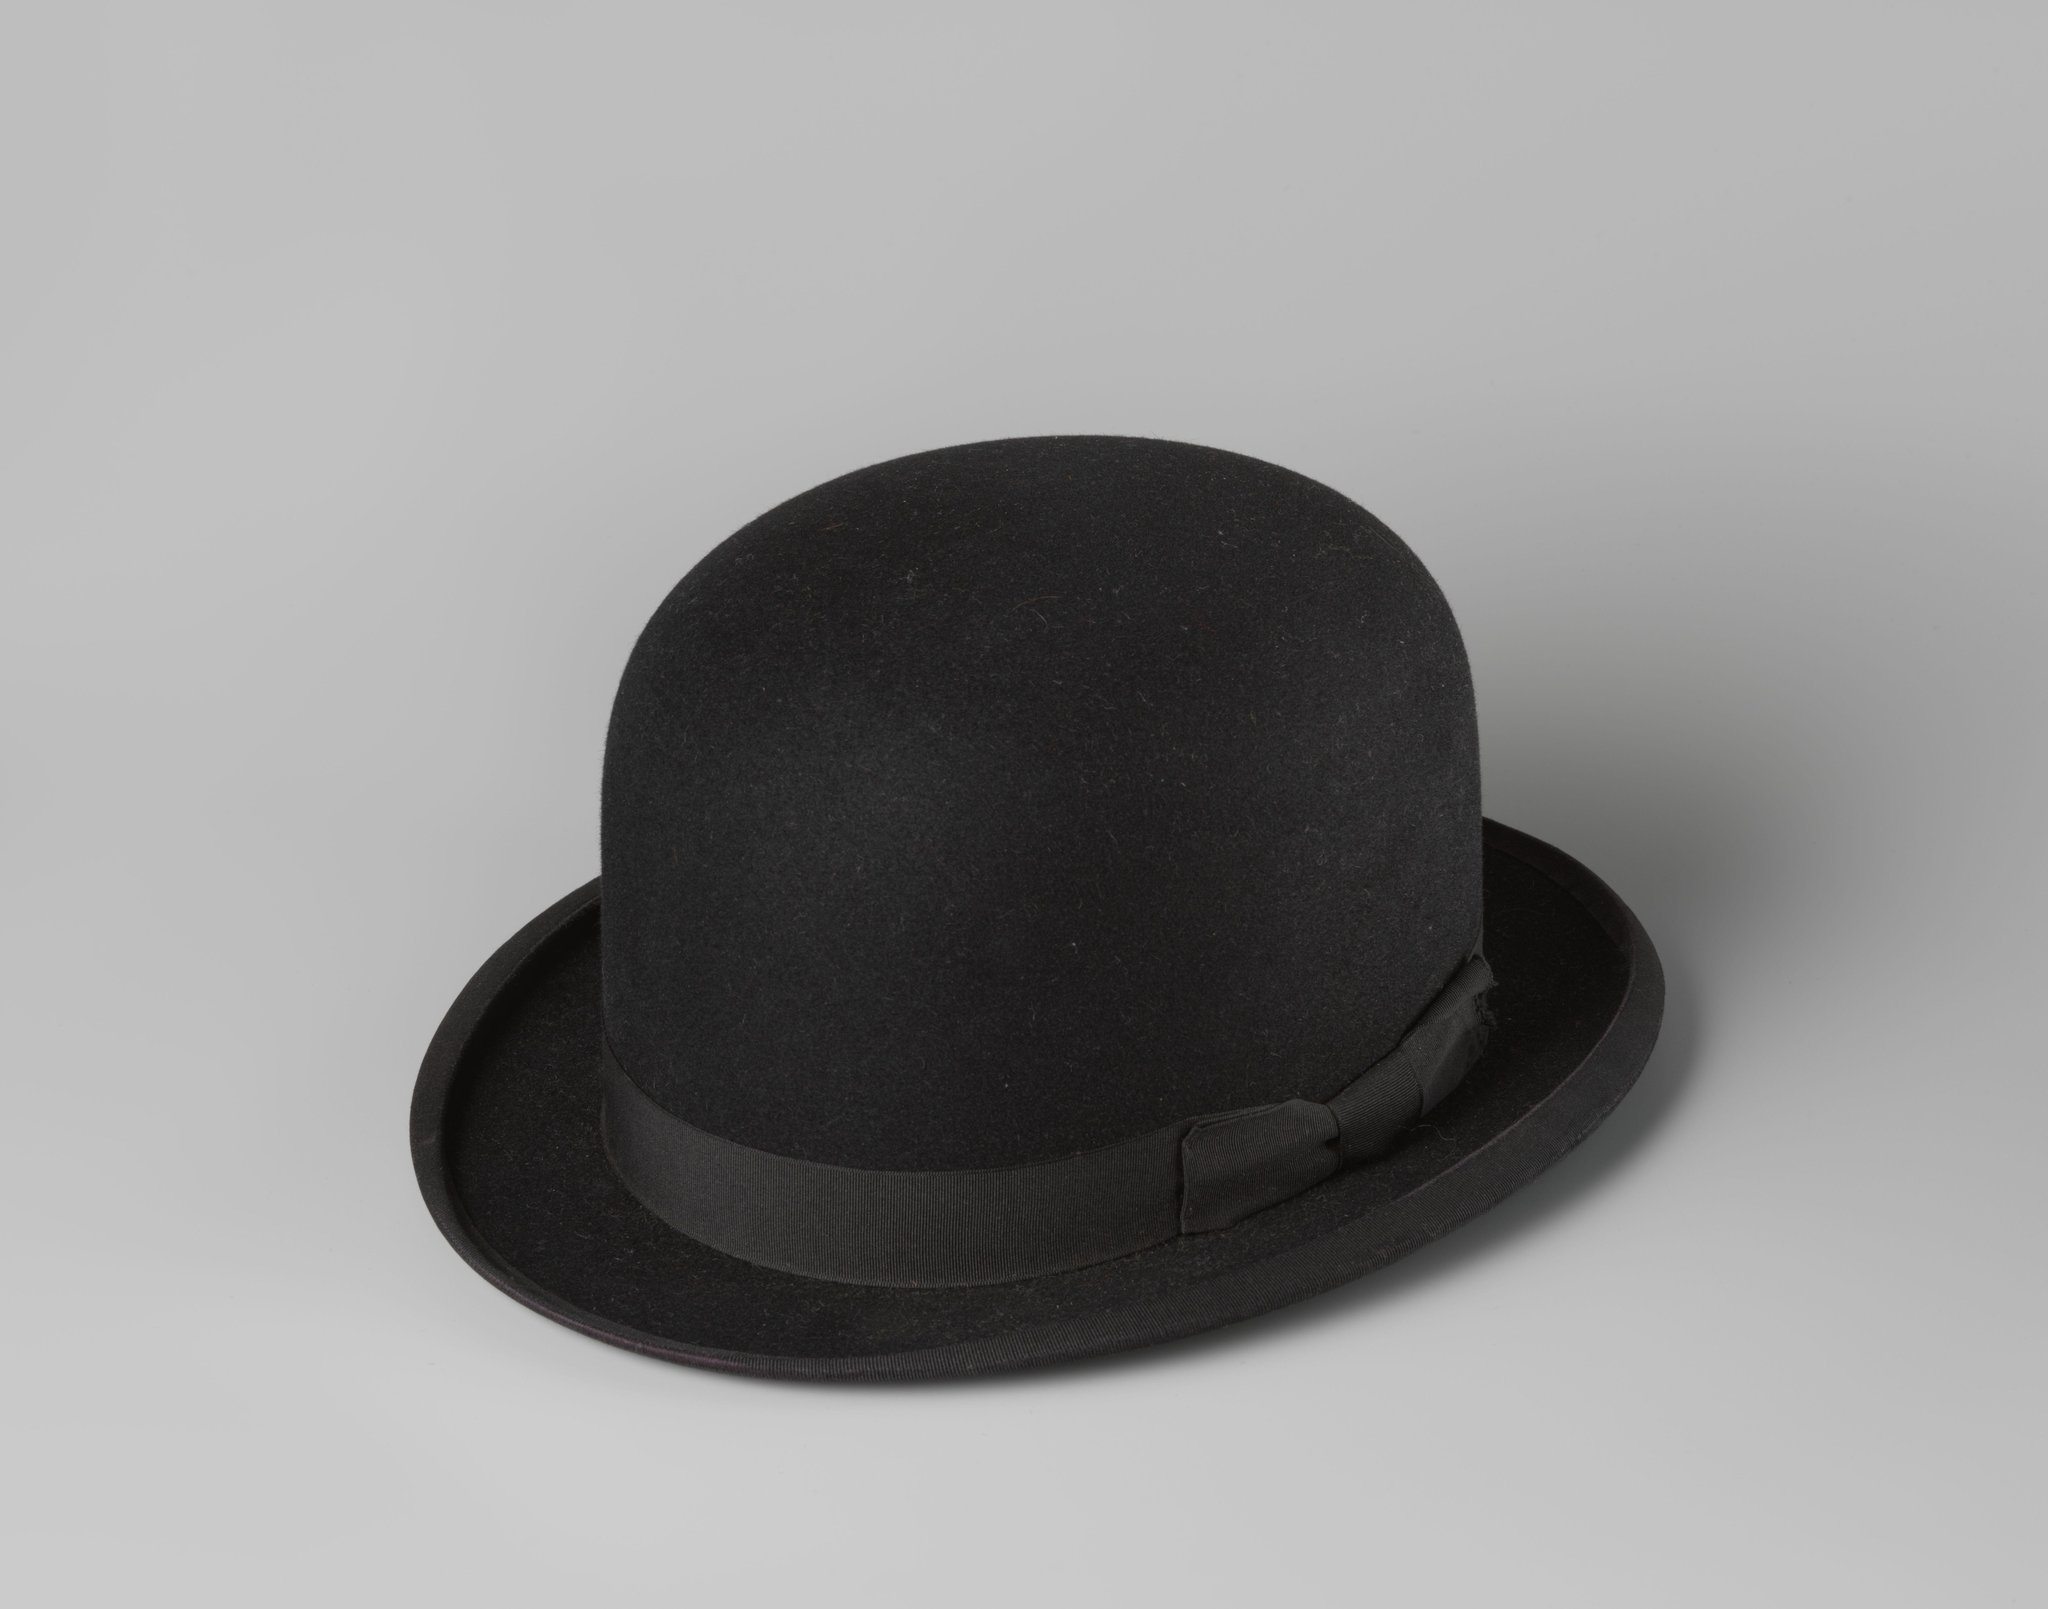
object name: dophoed, bolhoed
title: Bolhoed van een rijkostuum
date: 1934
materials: cotton, textile, felt, leather, silk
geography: london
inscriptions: address: ‘SELFRIDGE/LONDON’, address: ‘ELLWOOD/ & SONS'/ MANUFACTURE/LONDON’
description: Bolhoed met harde, hoge bol en aan weerskanten licht opstaande rand. Gevoerd met wit satijn en voorzien van hoedband van wit leer en met molton gevoerde beige zijde. De witte leren rand is voorzien van gaatjes waar een wit katoenen koord doorheen geregen is. De zijde/molton band is doorgestikt. Zwart hoedenelastiek. Versiering: om de bol zwart zijden grosgrain dat aan de linkerkant in een platte strik is gestrikt. De rand is rondom afgezet met zart grosgrain. Adres: ELLWOOD/ & SONS'/ MANUFACTURE/LONDON en SELFRIDGE/LONDON.